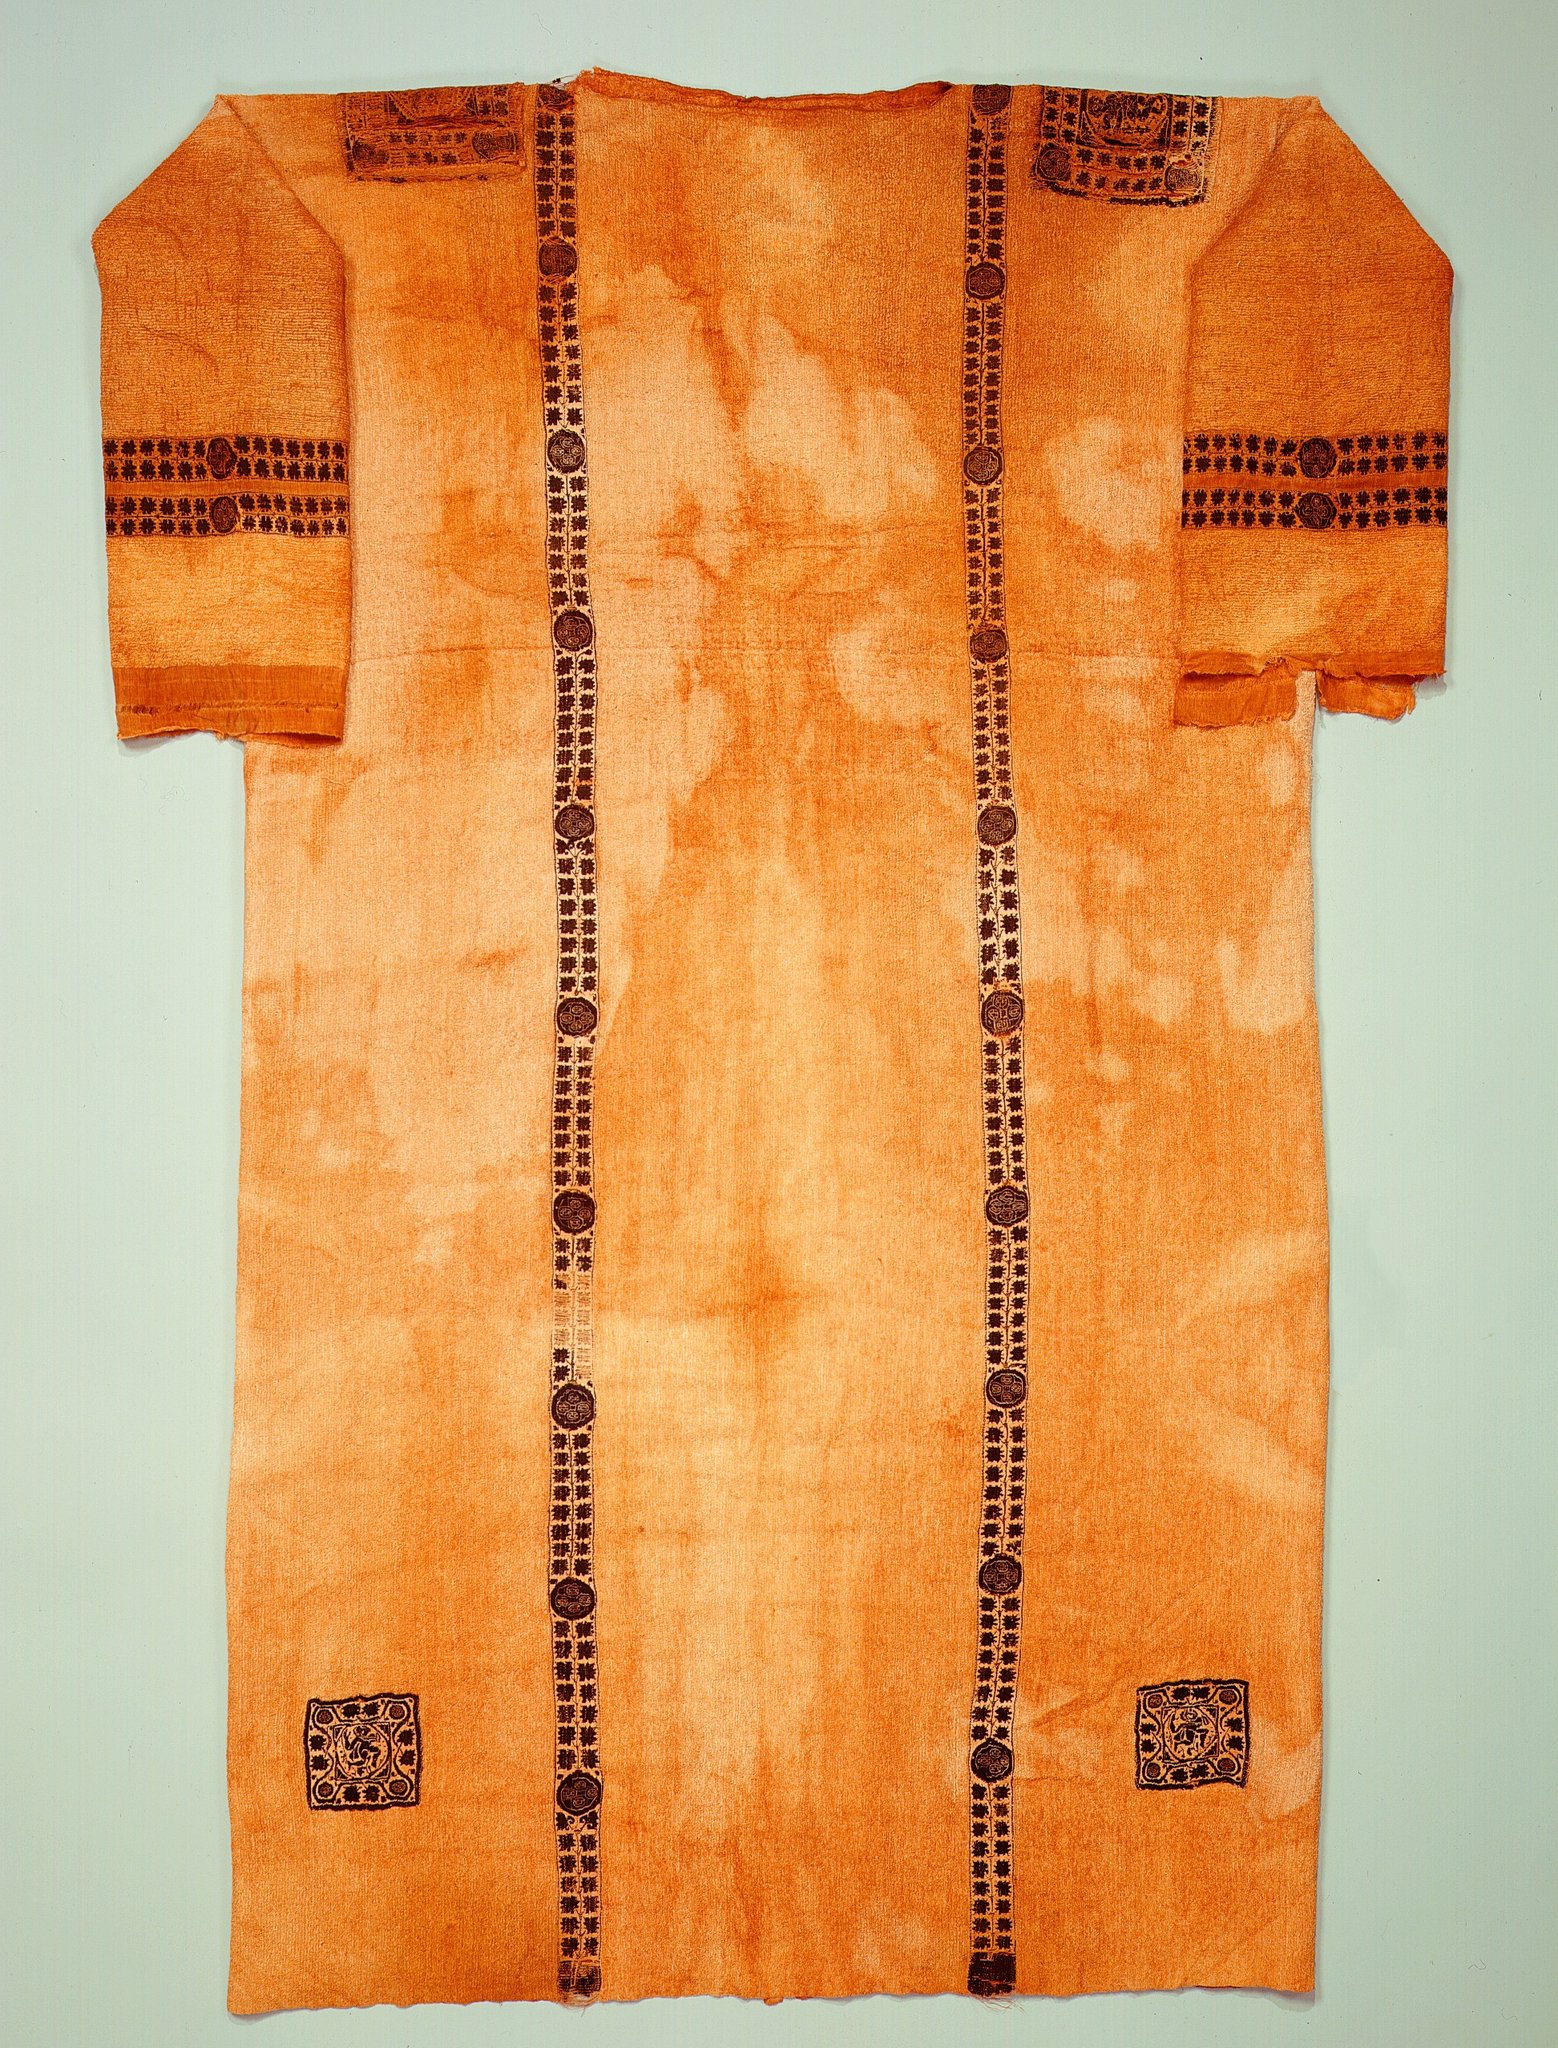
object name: tunic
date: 401-500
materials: linen, wool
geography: egypt